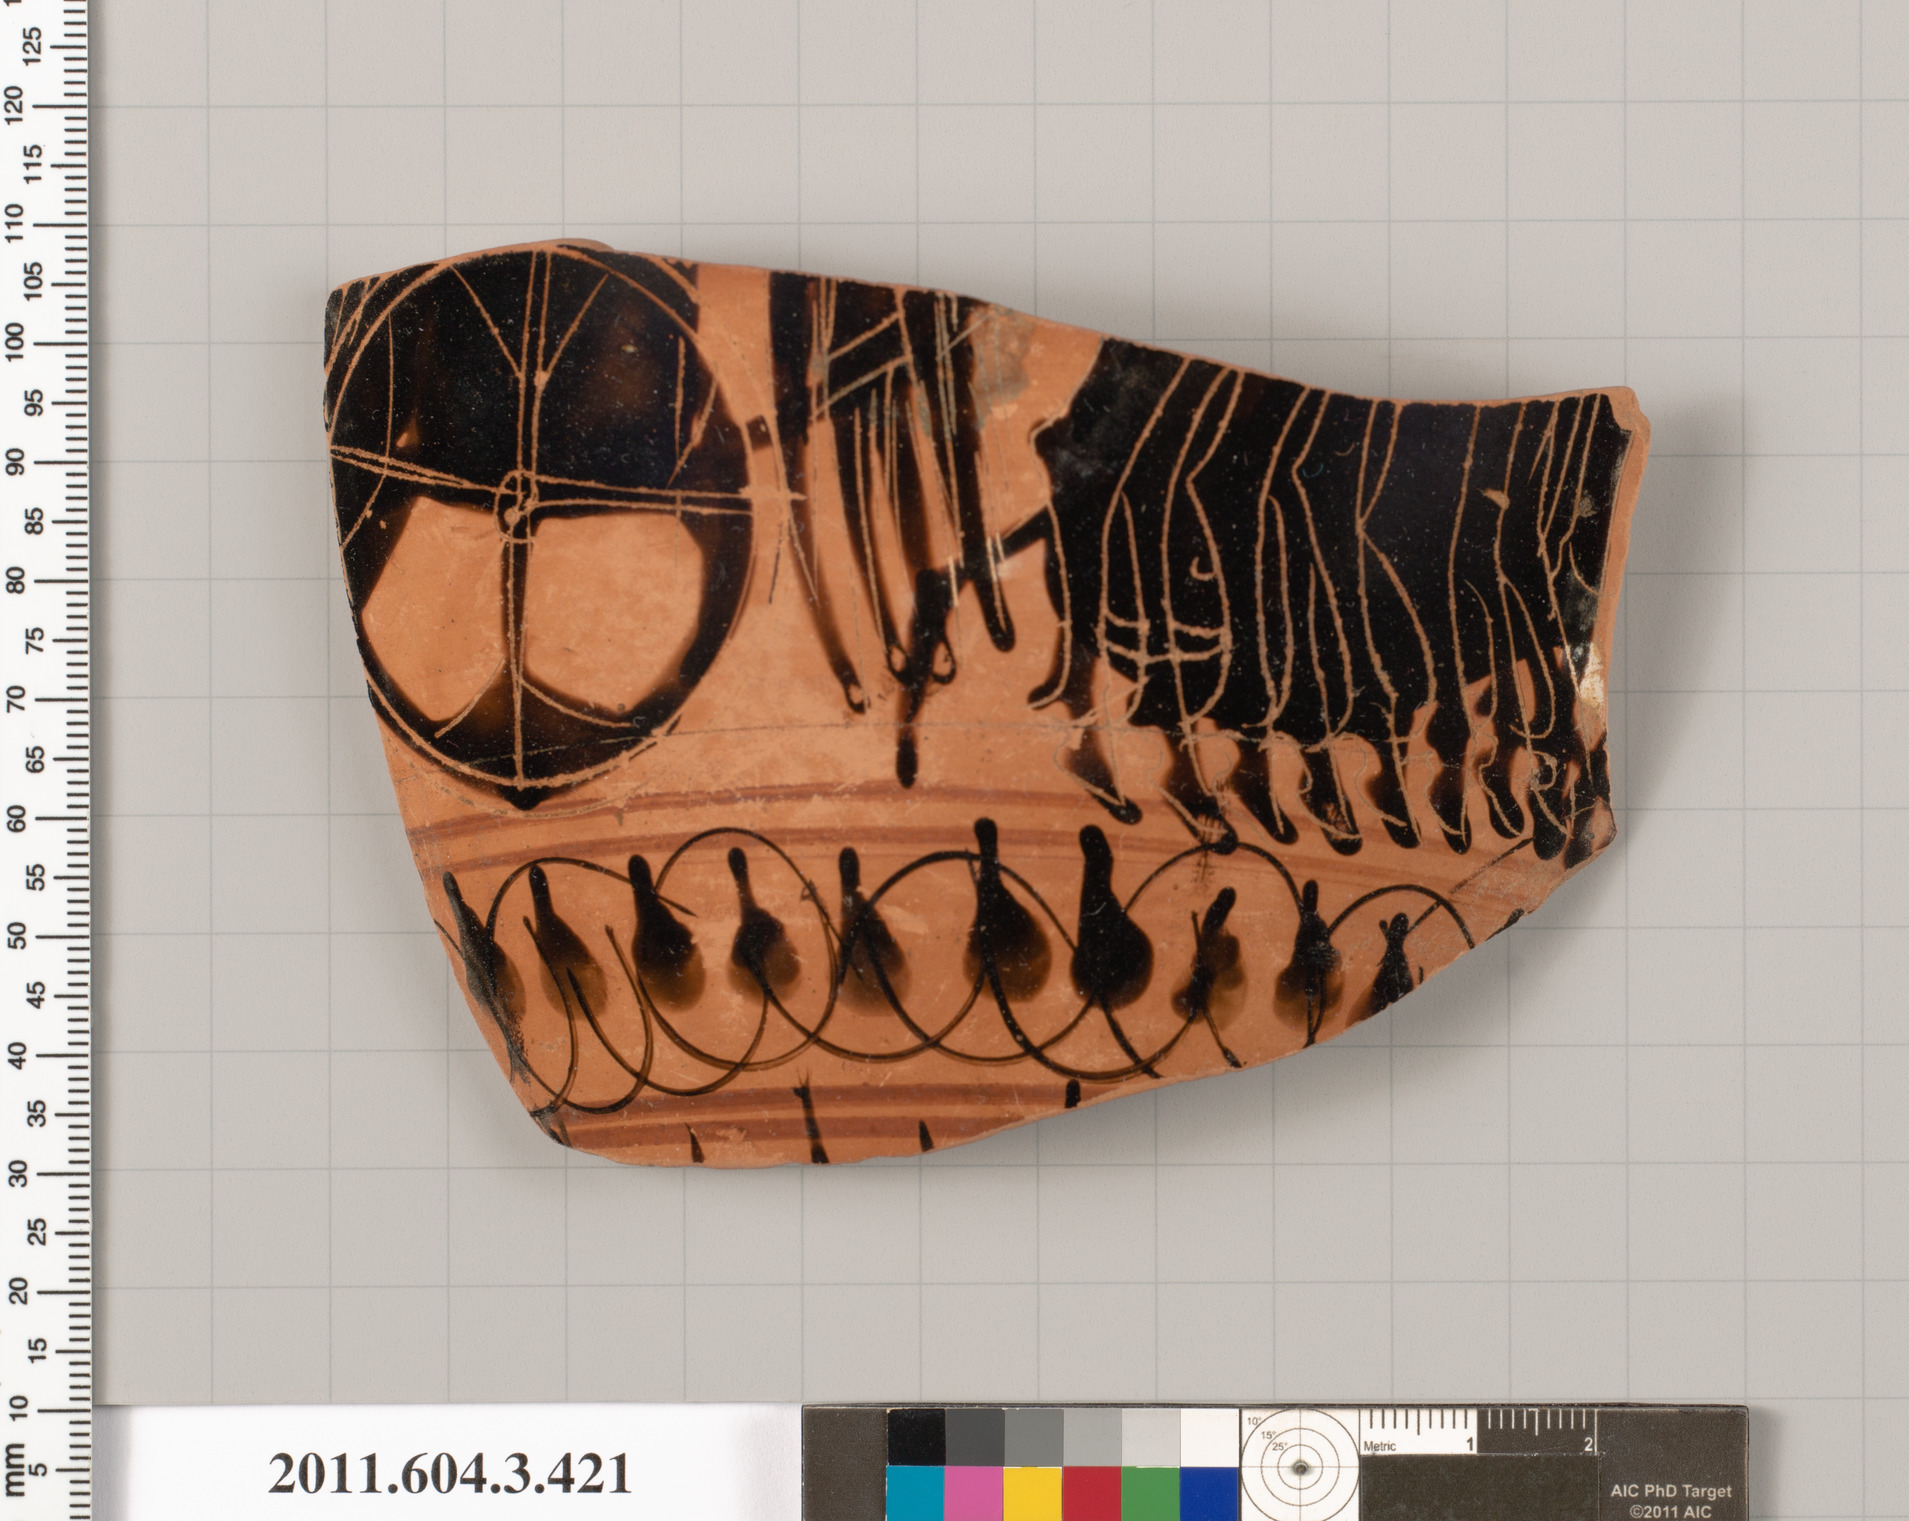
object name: neck amphora fragment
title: Terracotta fragment of a neck-amphora (jar)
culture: greek, attic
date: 520-510 BCE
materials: terracotta